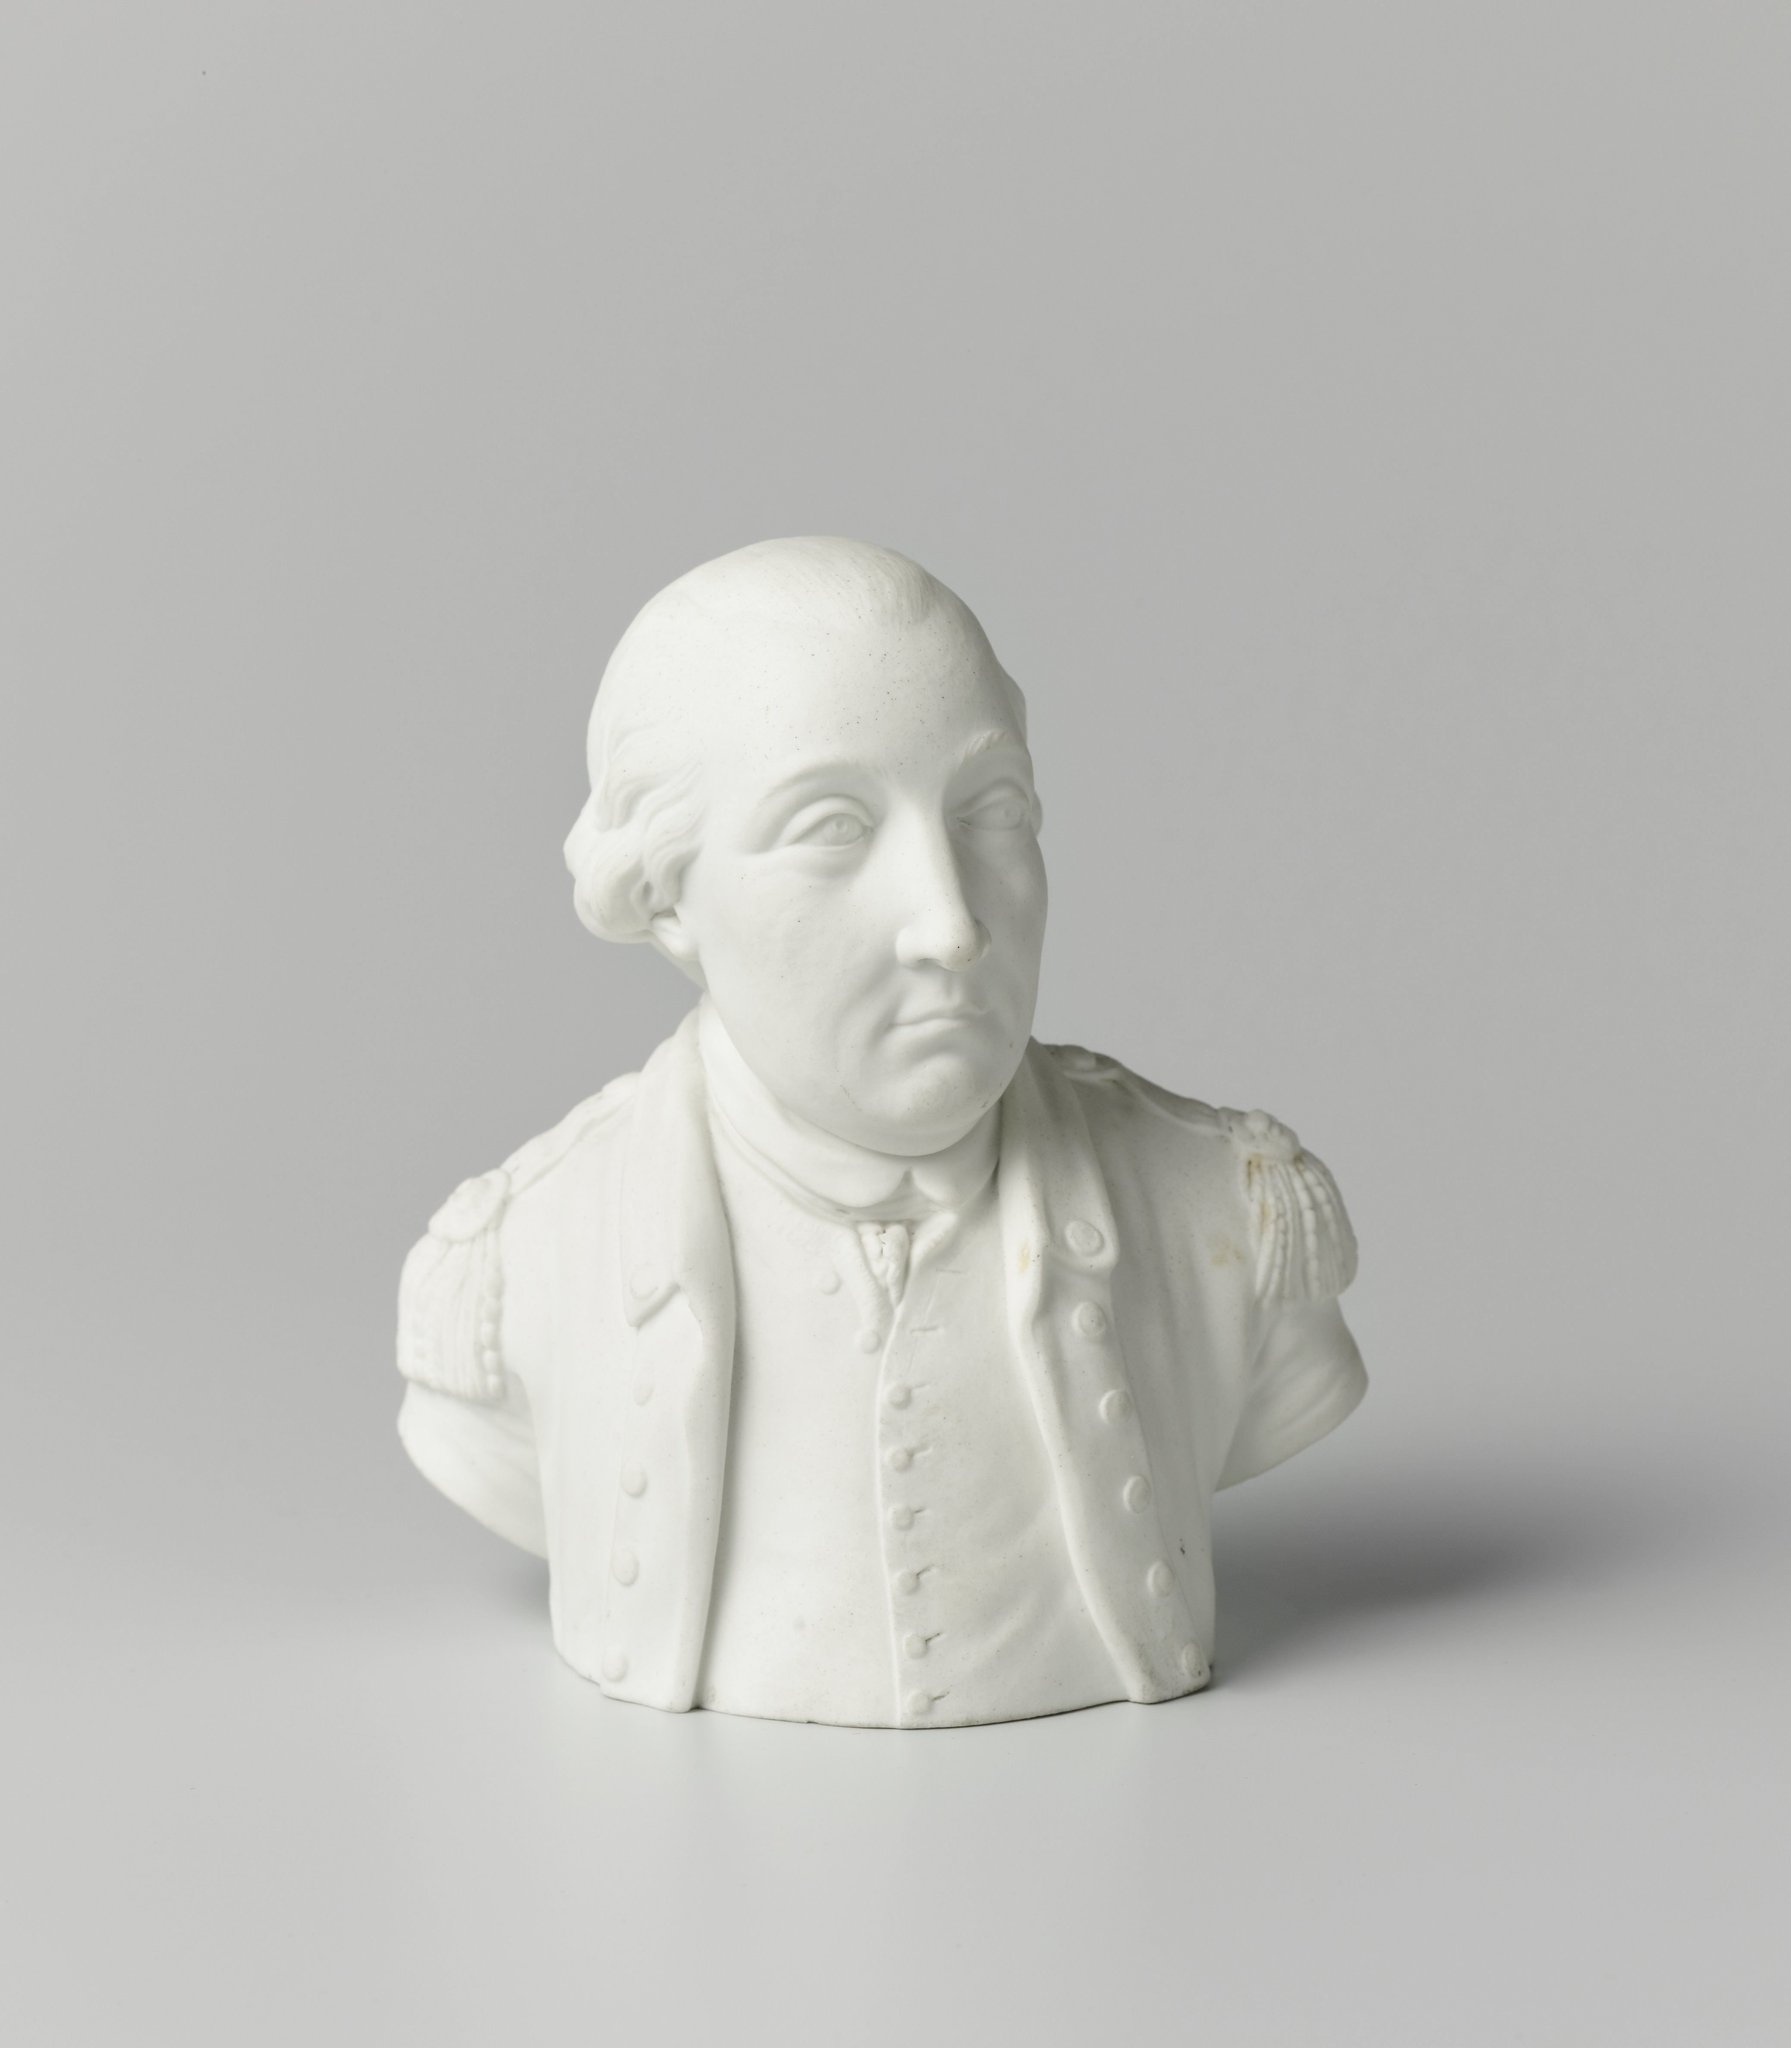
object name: bust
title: Wolter Jan Gerrit baron Bentinck (1745-1781)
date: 1782-1784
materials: biscuit porcelain, material)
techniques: biscuit (porcelain, material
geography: loosdrecht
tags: amsterdam, historical persons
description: Buste van biscuit, voorstellende Wolter Jan Gerrit baron Bentinck (1745-1781) in uniform met epauletten en pruik in Lodewijk XV-stijl.